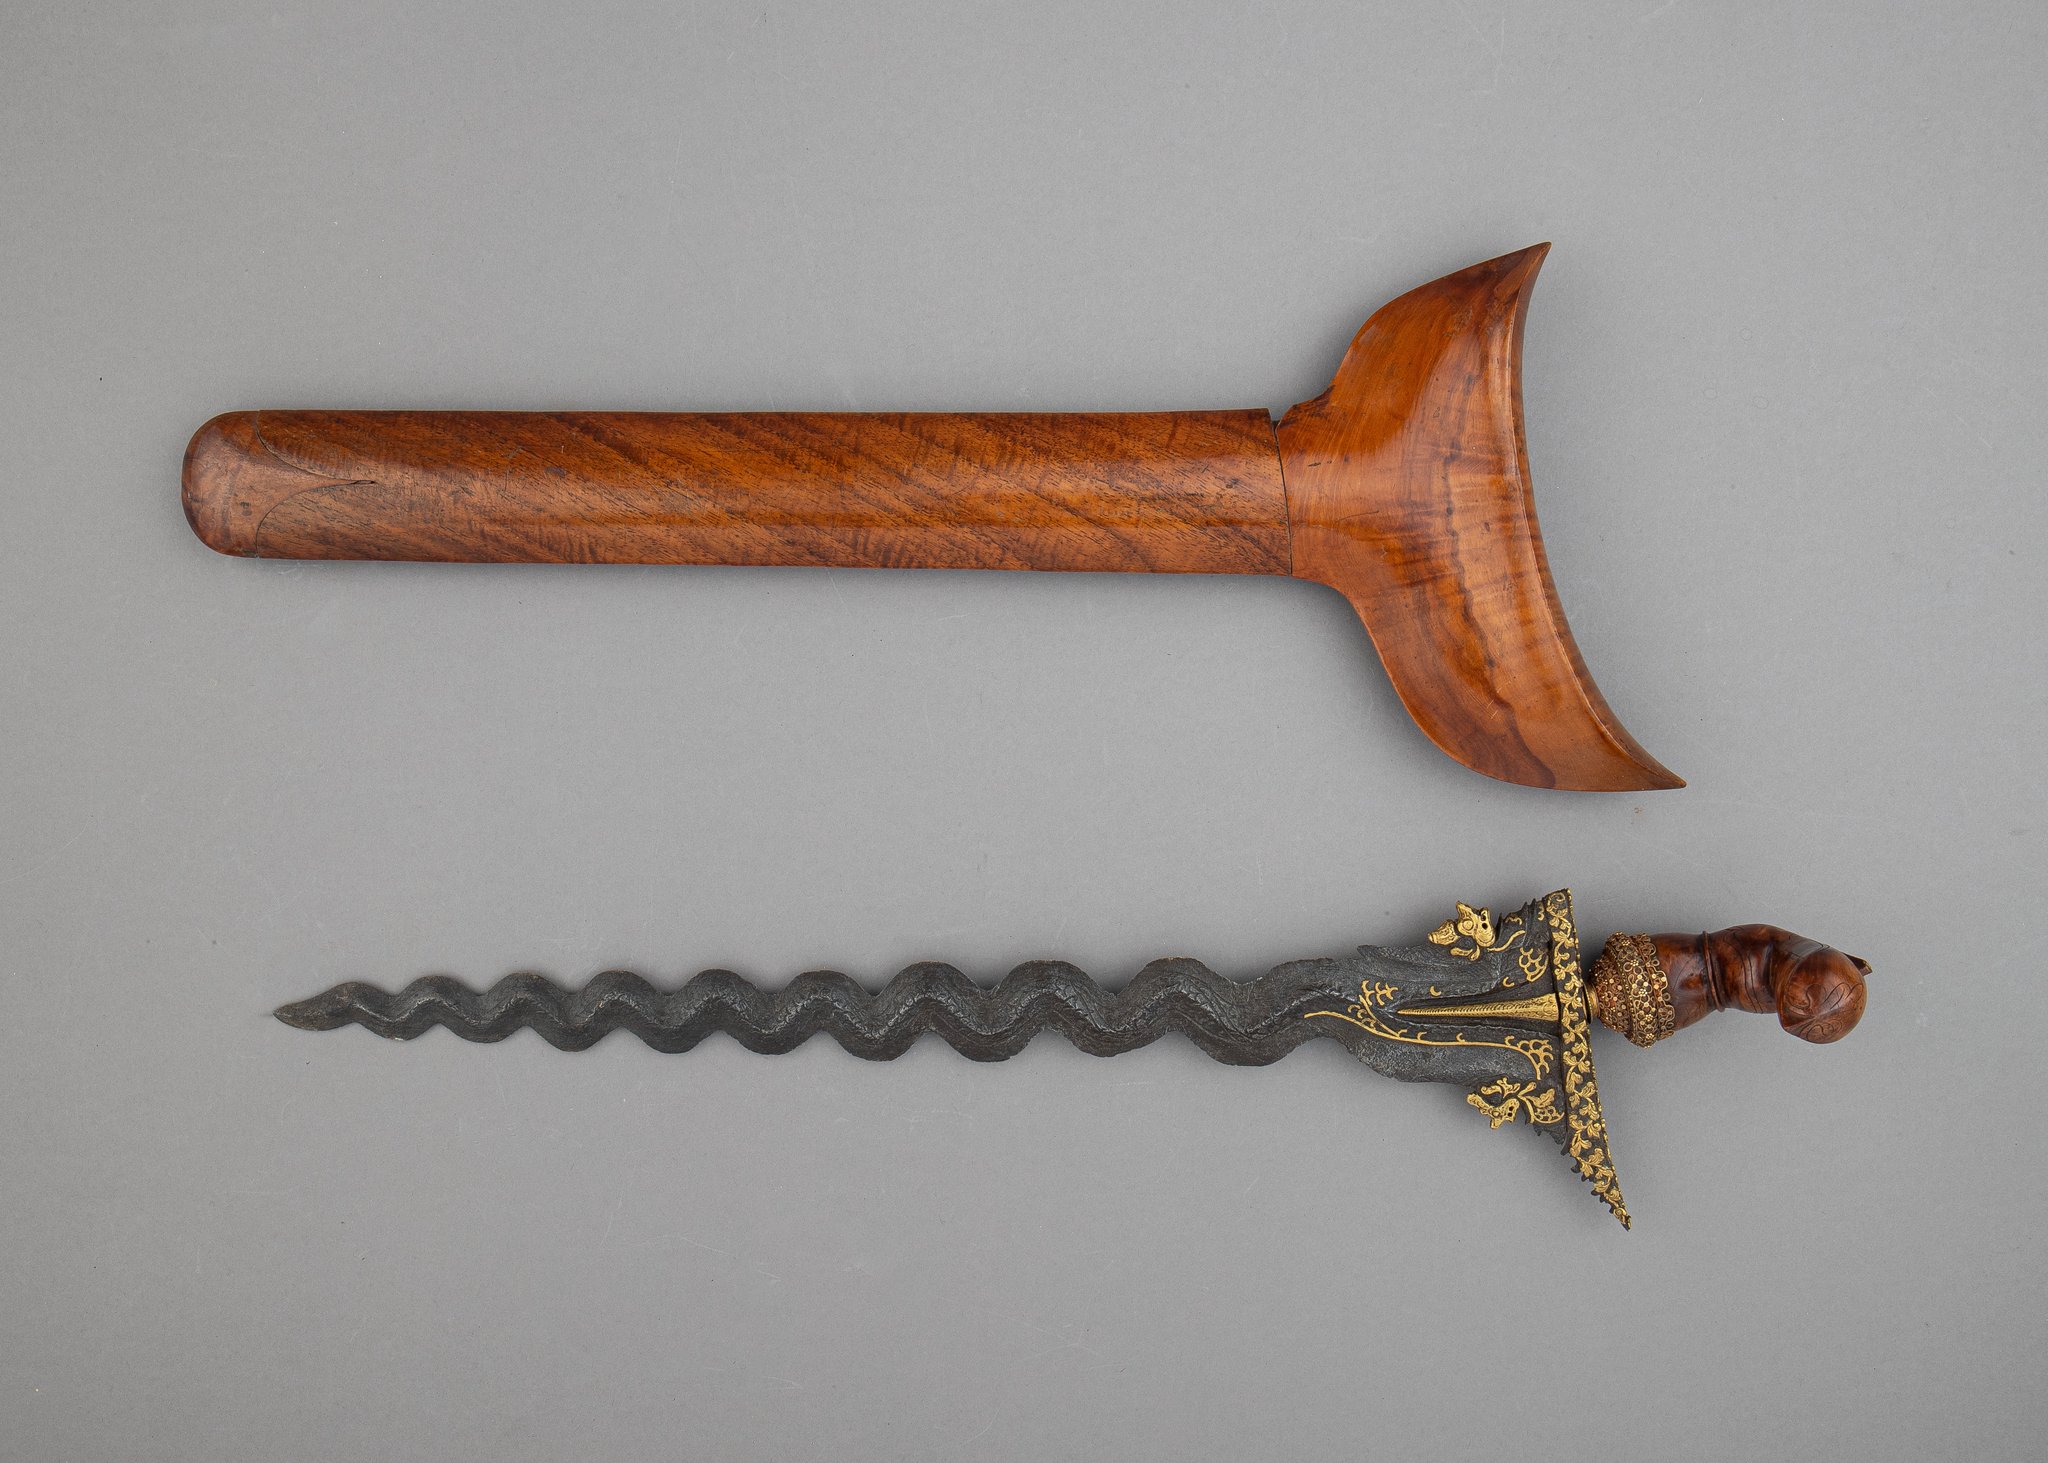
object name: kris with sheath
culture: indonesian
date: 1701-1900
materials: copper alloy, gold, steel, wood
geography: indonesia